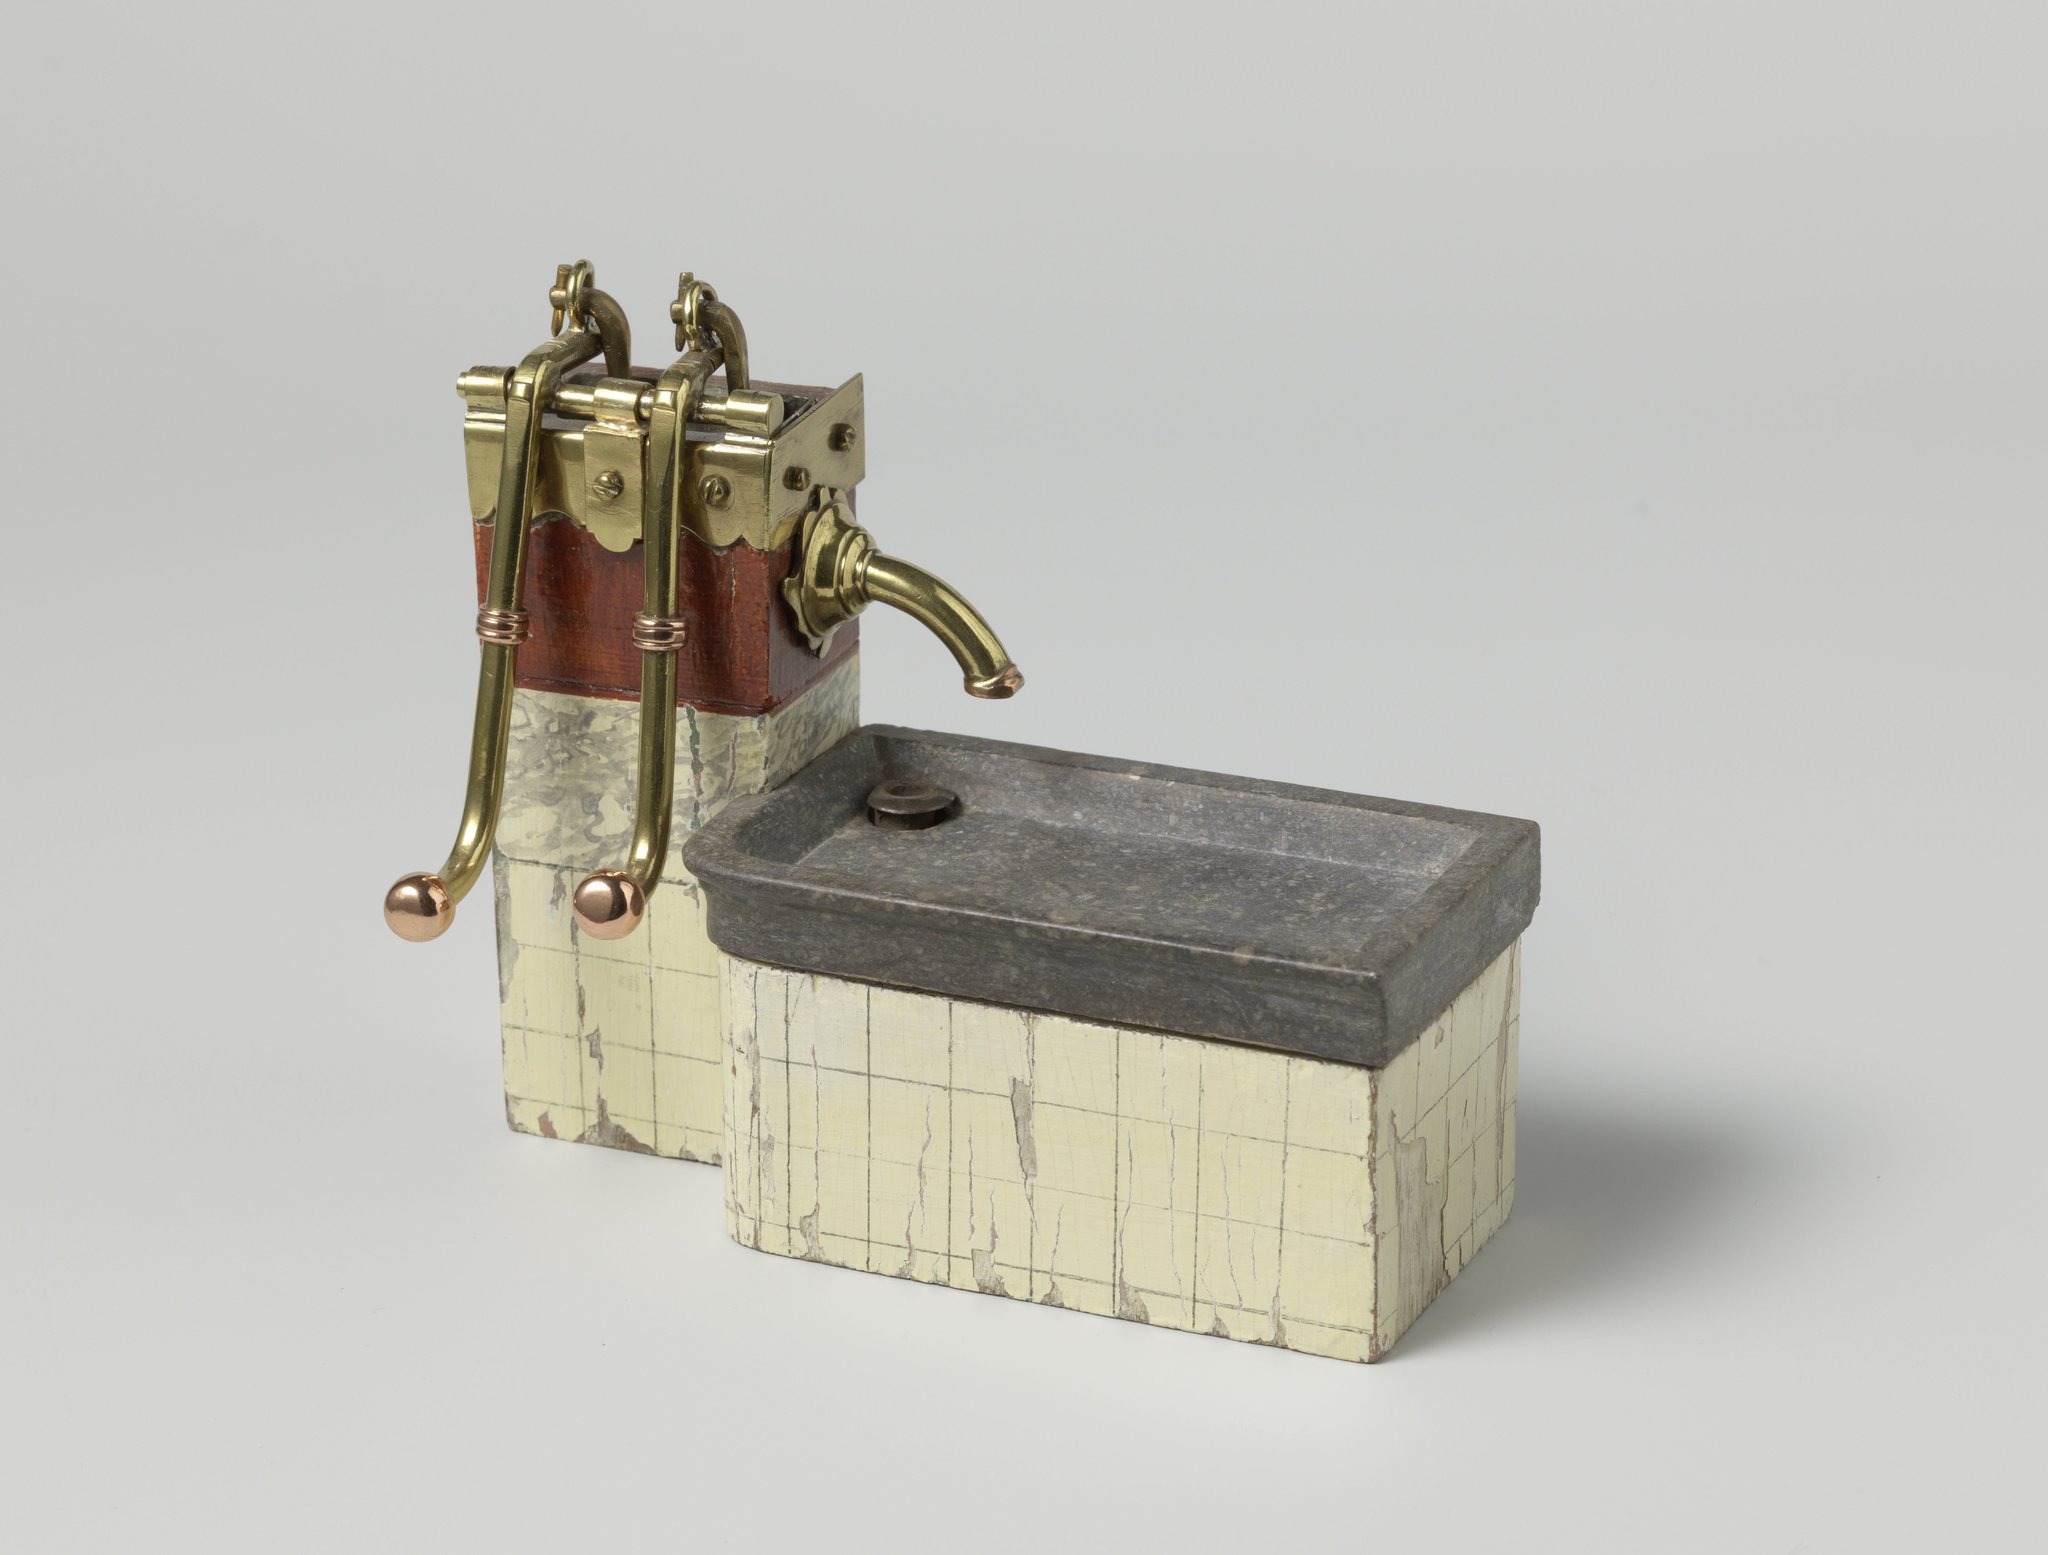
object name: pump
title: Pomp met twee zwengels en gootsteenbak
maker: Anonymous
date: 1750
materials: brick, brass, copper, wood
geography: amsterdam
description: Pomp van hout, beschilderd aan de voor- en zijkant met tegelpatroon, daarboven gemarmerd en gehout, passend bij de keuken, achterkant effen bruinkleurig. Gootsteen van hardsteen met koperen afvoer, twee geelkoperen zwengels met roodkoperen ring- en knopversiering, geel koperen sierrand en kraan. Pompconstructie van binnen volledig uitgevoerd als pompen op ware grootte.